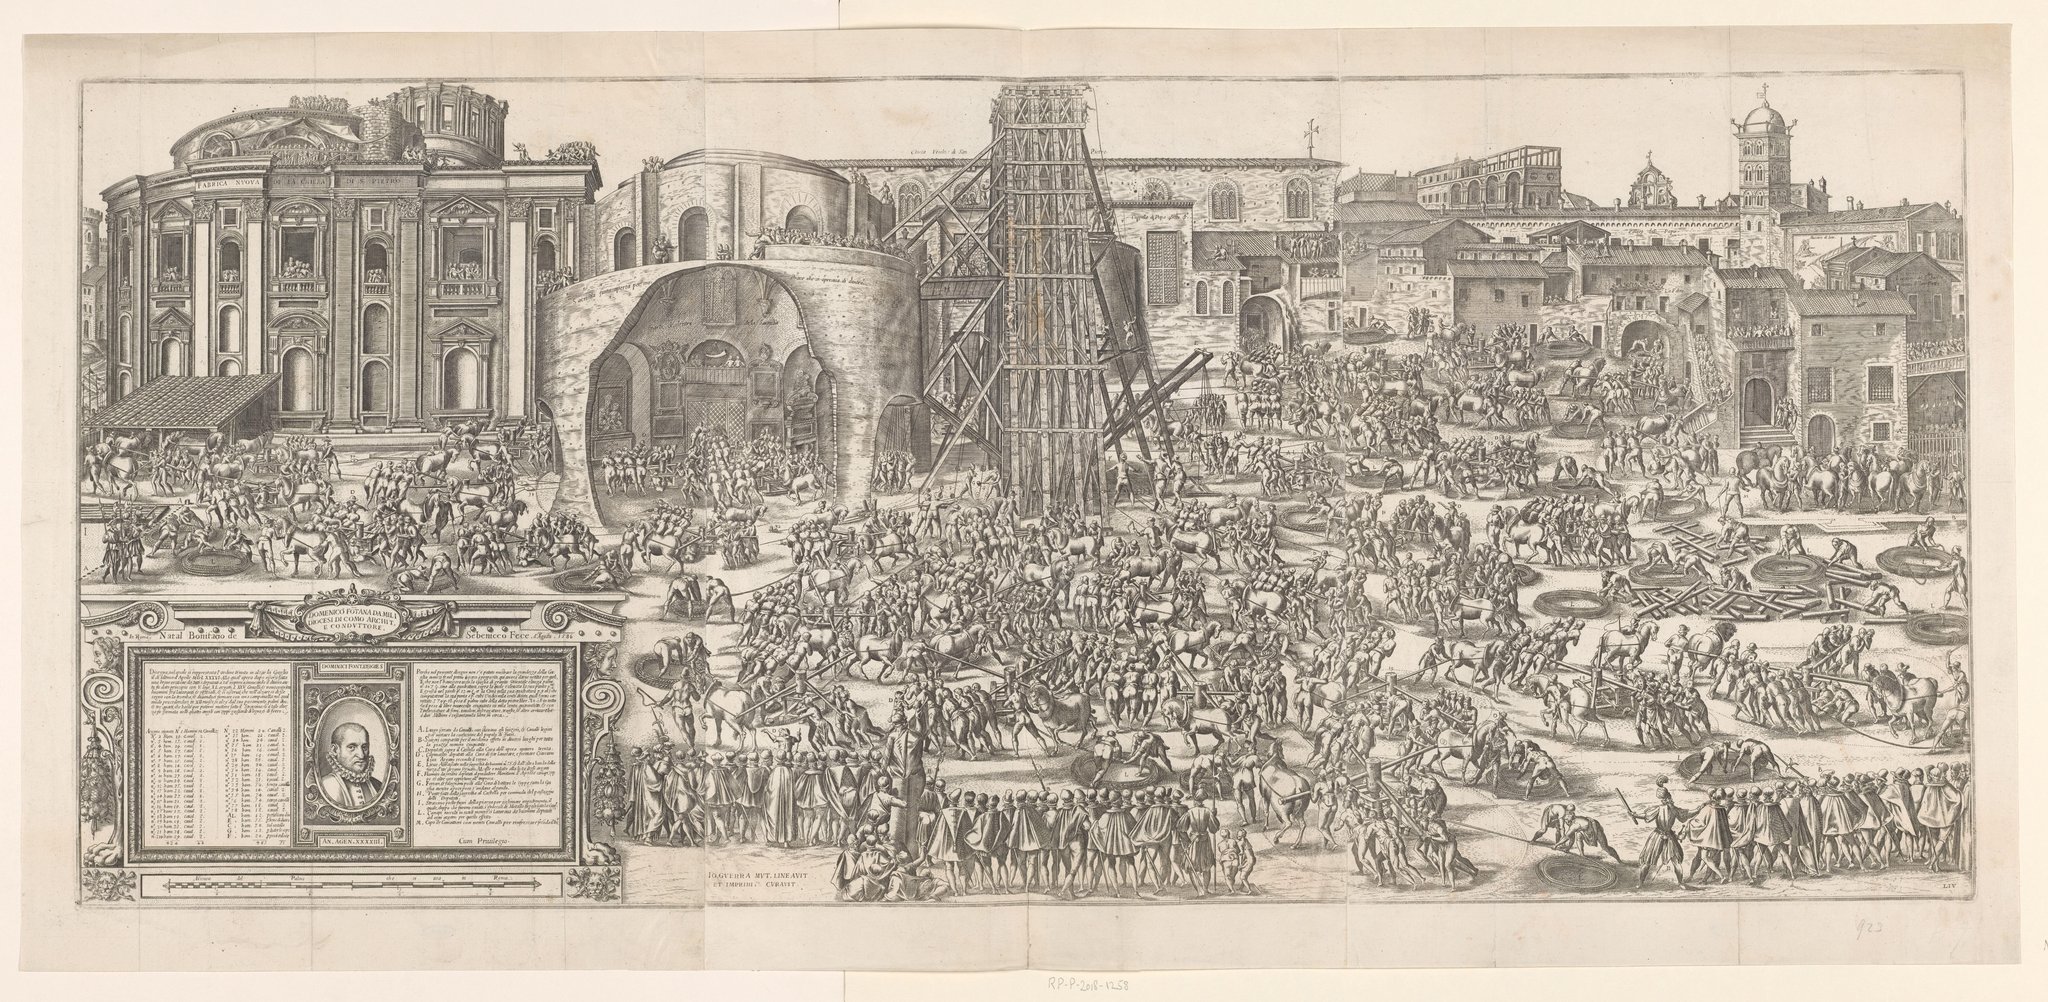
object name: print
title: De oprichting van de obelisk op het St. Pietersplein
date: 1586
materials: paper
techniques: engraving, etching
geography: rome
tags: switzerland, domenico fontana, obelisk, needle, historical persons, roman catholic church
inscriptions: collector's mark: Lugt 2228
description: Mannen en paarden zijn voor de Sint-Pietersbasiliek bezig met het oprichten van de Vaticaanse Obelisk (in 1586) op het St. Pietersplein. Linksonder een verklarende lijst met nummers en letters en het portret van Domenico Fontana, de architect die de hele verplaatsing en oprichting van de obelisk overzag. Rechtsonder genummerd: LIV.